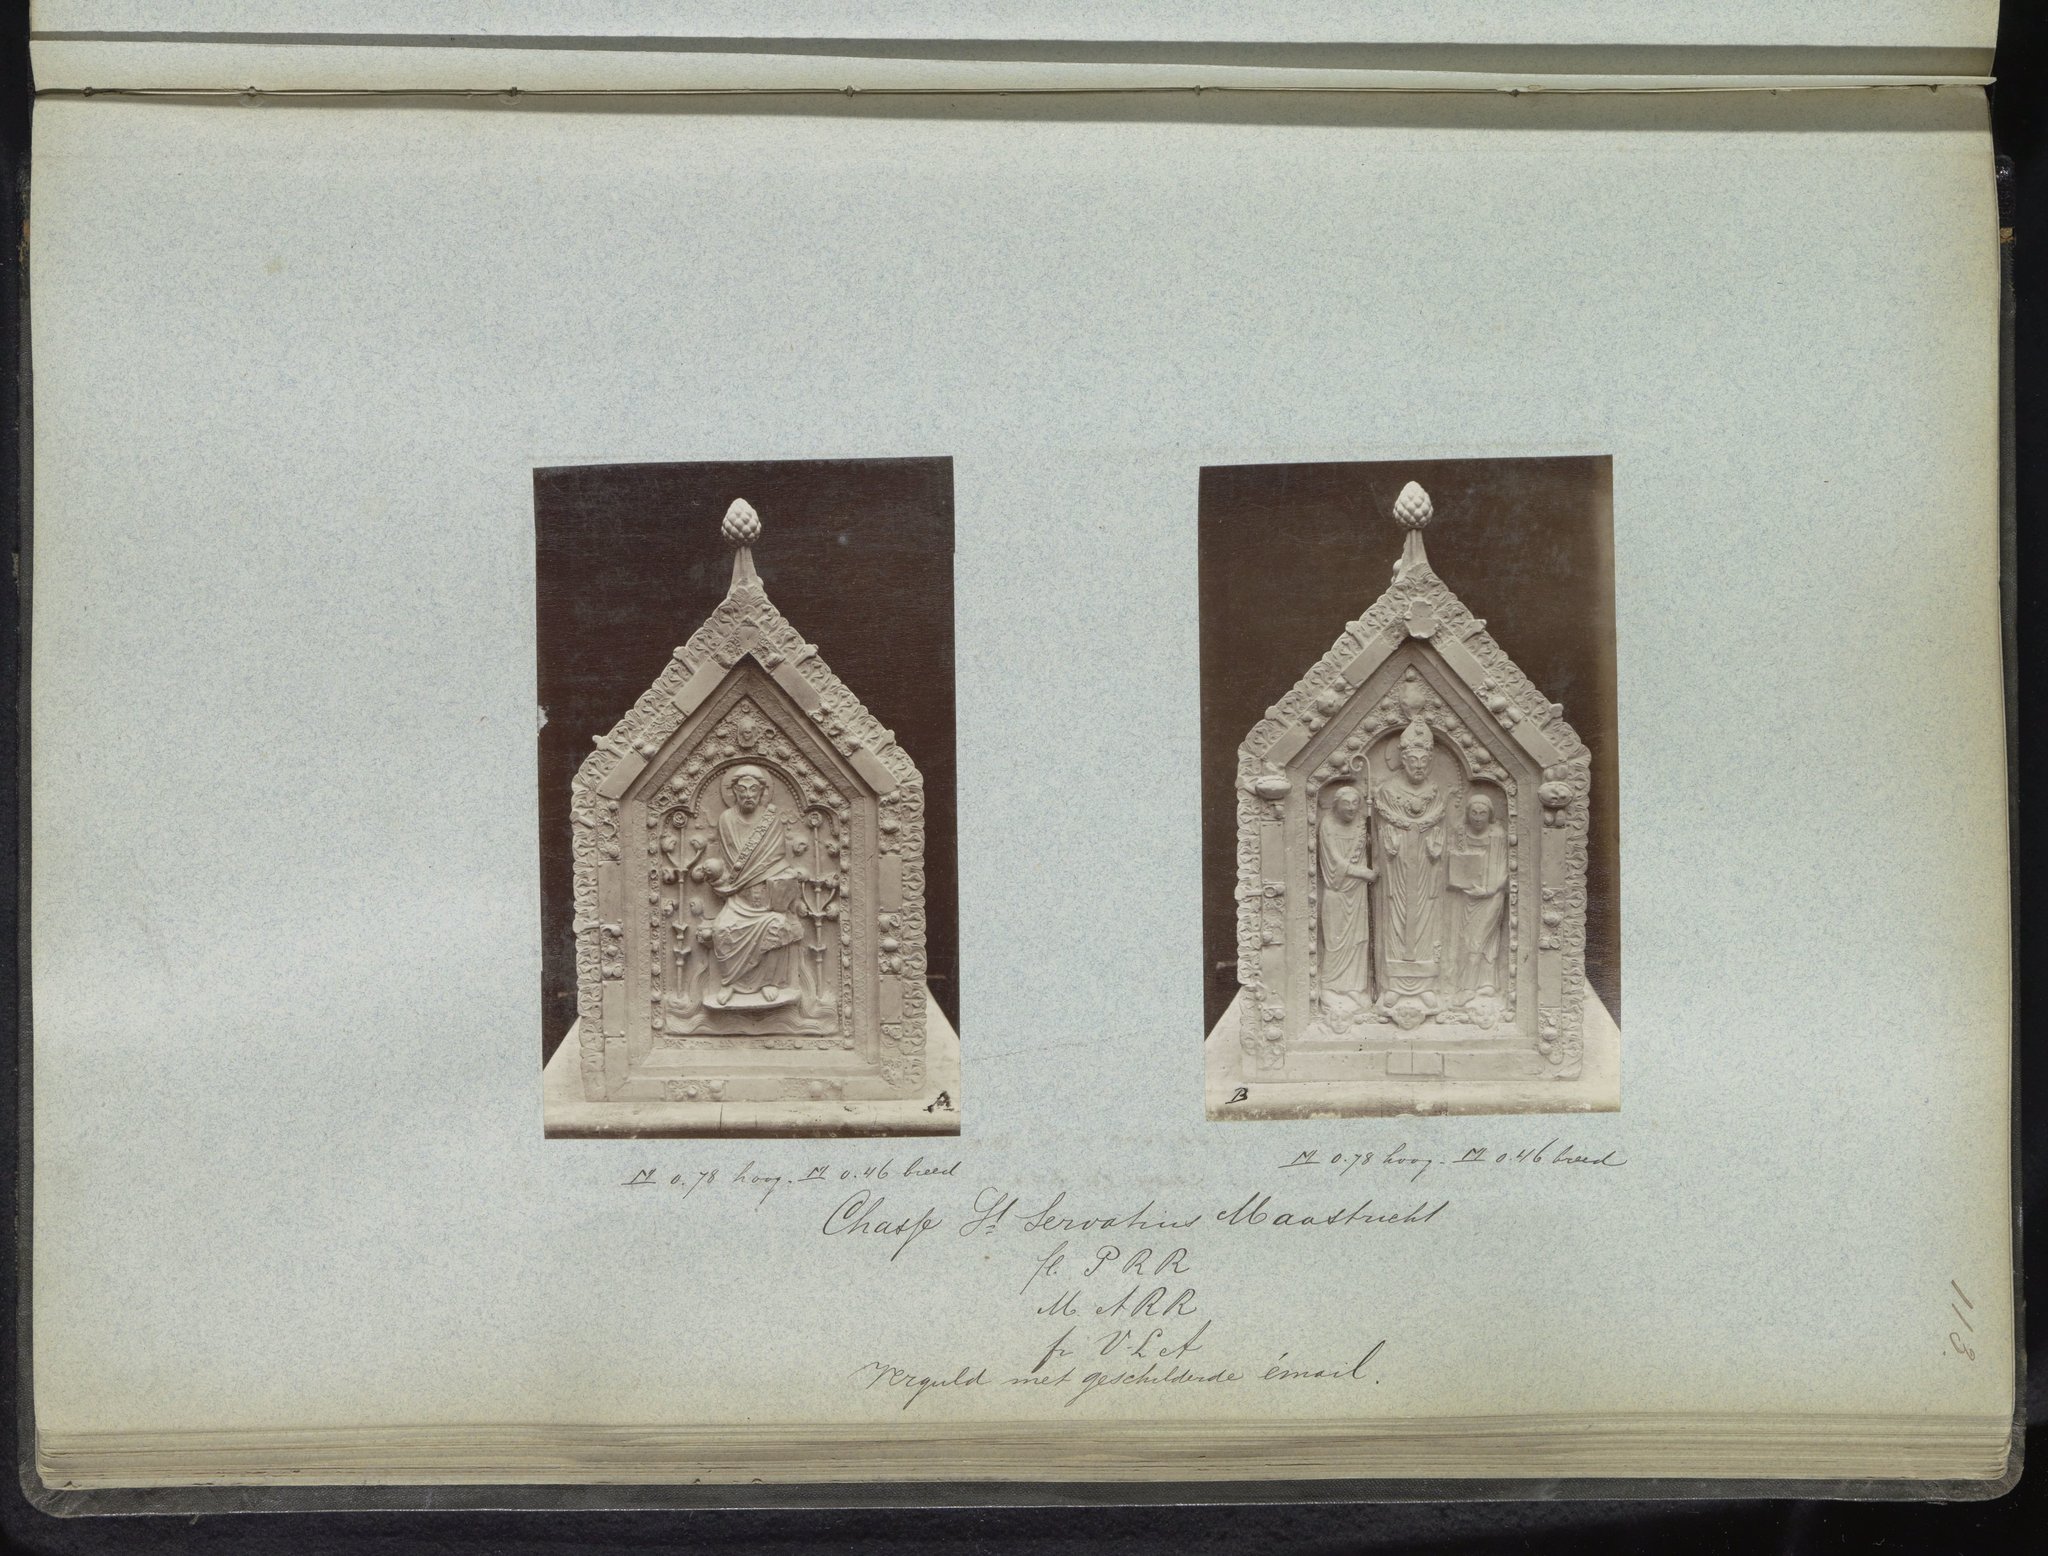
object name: album leaf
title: Gipsen afgietsel van een sculptuur uit de Sint-Servaasbasiliek te Maastricht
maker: Anonymous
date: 1875-1900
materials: paper, photographic support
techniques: albumen print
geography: maastricht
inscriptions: annotation: ‘Verguld met geschilderd email’, annotation: ‘[...] St. Servatius Maastricht’, annotation, annotation: ‘M 0.78 hoog M 0.46 breed’